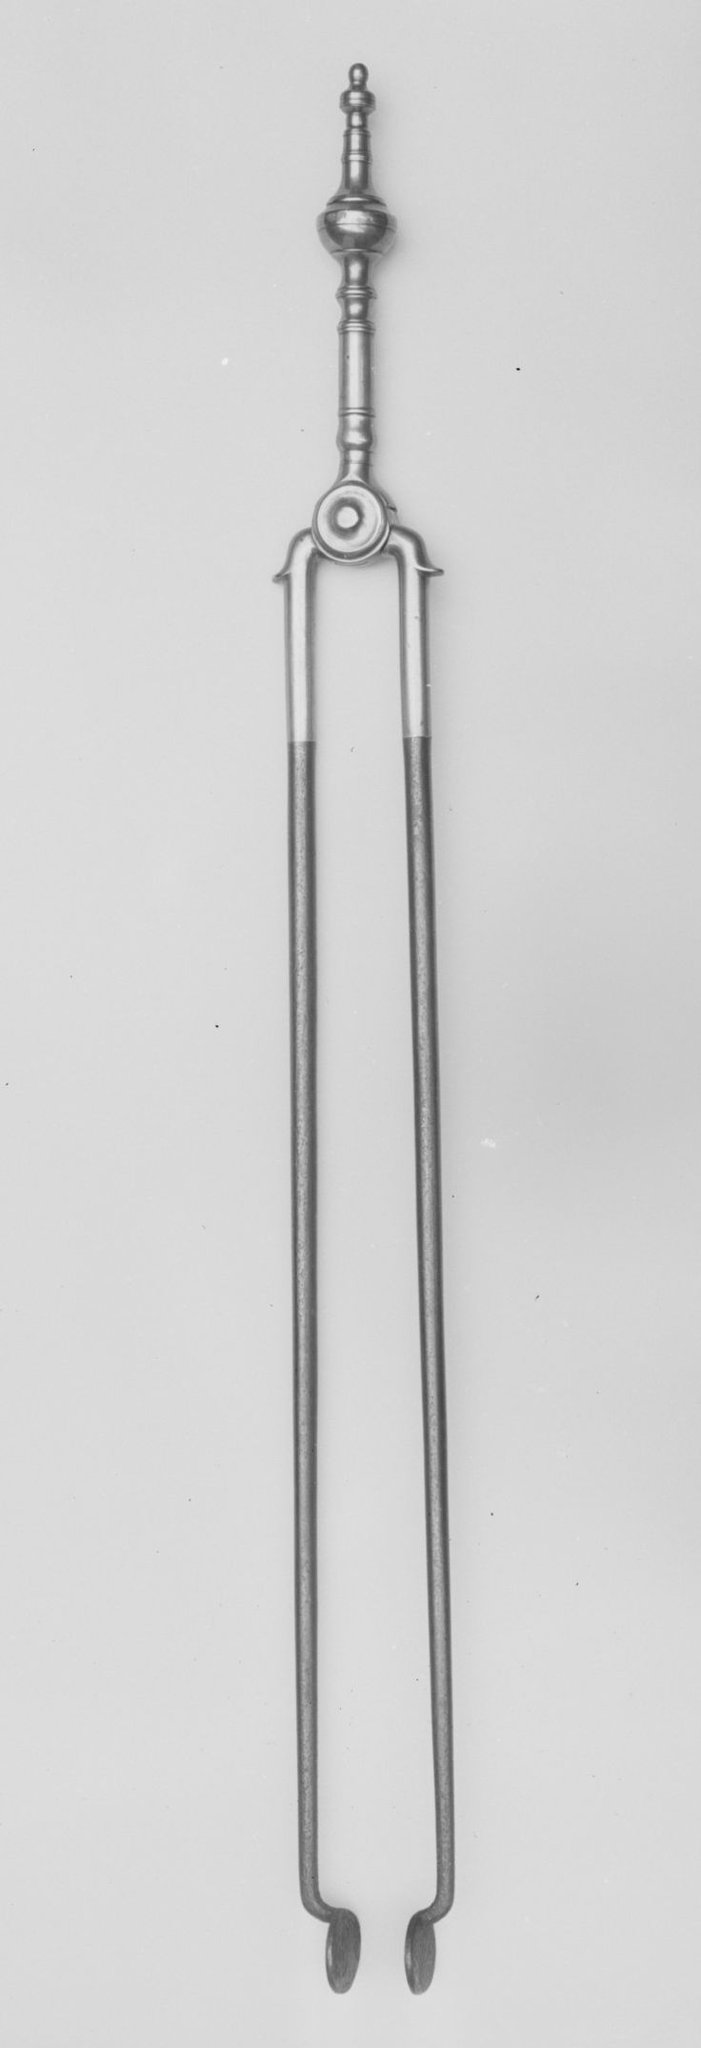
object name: fire tongs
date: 1770-1800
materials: brass